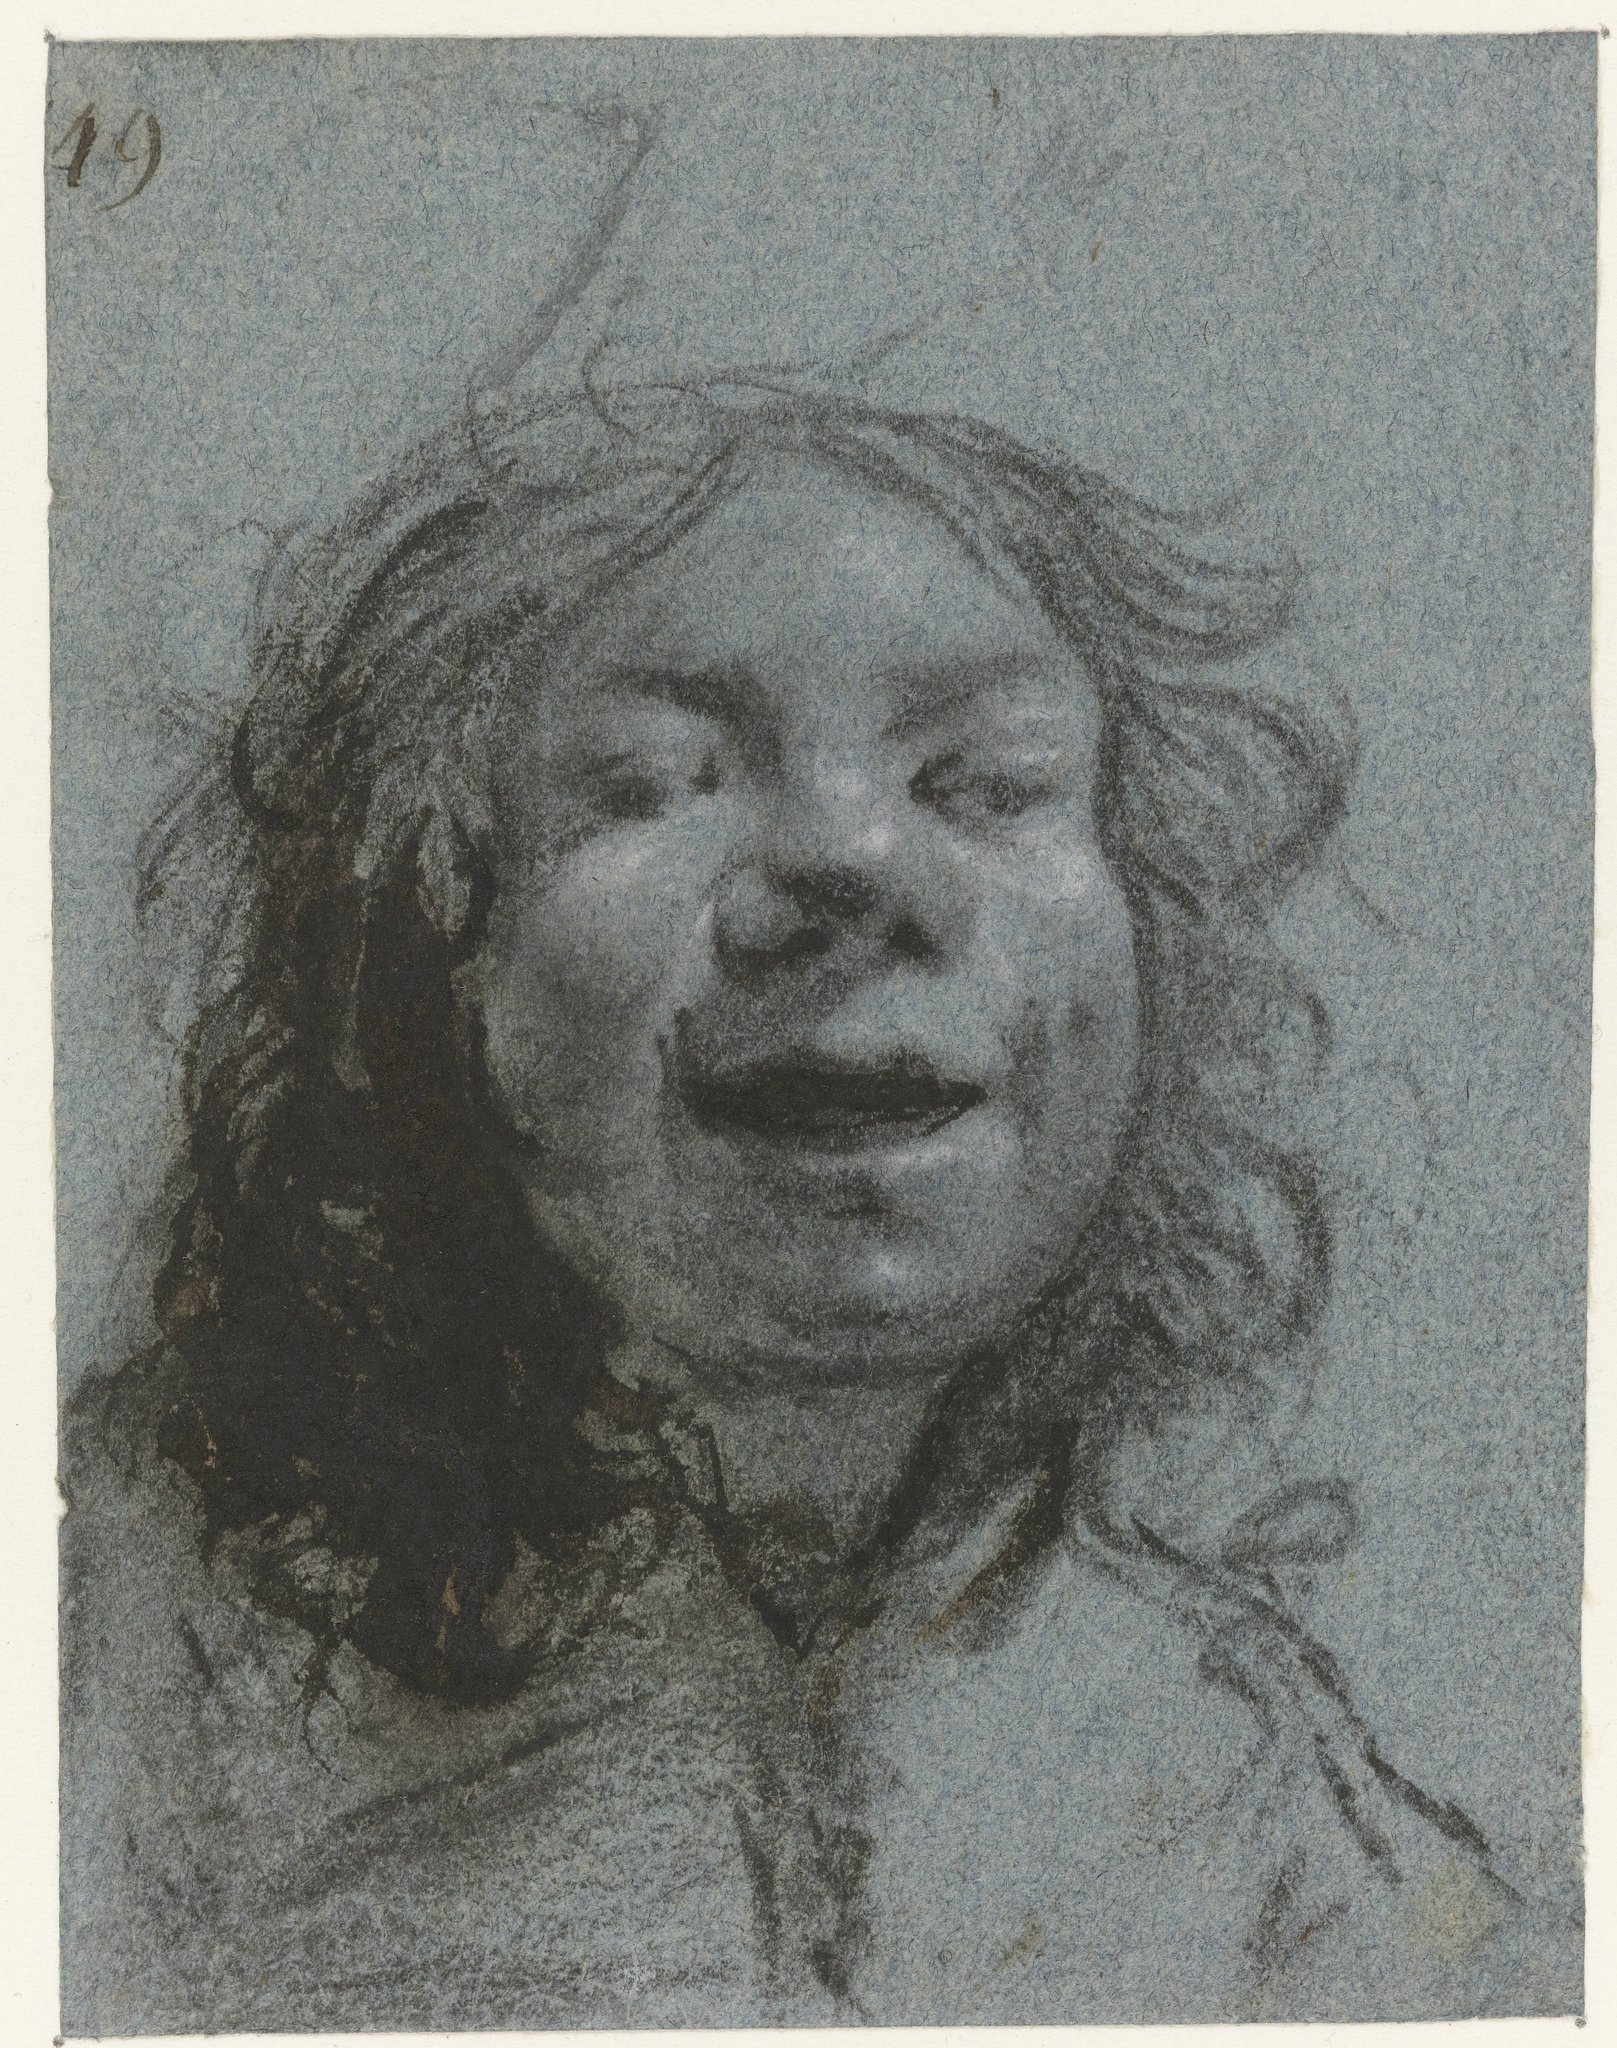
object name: drawing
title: Smiling Self-portrait, from the Front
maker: moses ter borch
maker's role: draughtsman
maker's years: 1645-1667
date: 1660-1661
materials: chalk, ink, paper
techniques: brush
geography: zwolle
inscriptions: annotation: ‘49; 149, 30 en 78’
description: Moses ter Borch was one of the few artists in the second half of the 17th century who, inspired by Rembrandt’s self-portraits, frequently studied his own face. The young artist recorded himself with different expressions in these three studies. Thus he is not looking out at us, but rather examining his reflection in a mirror.